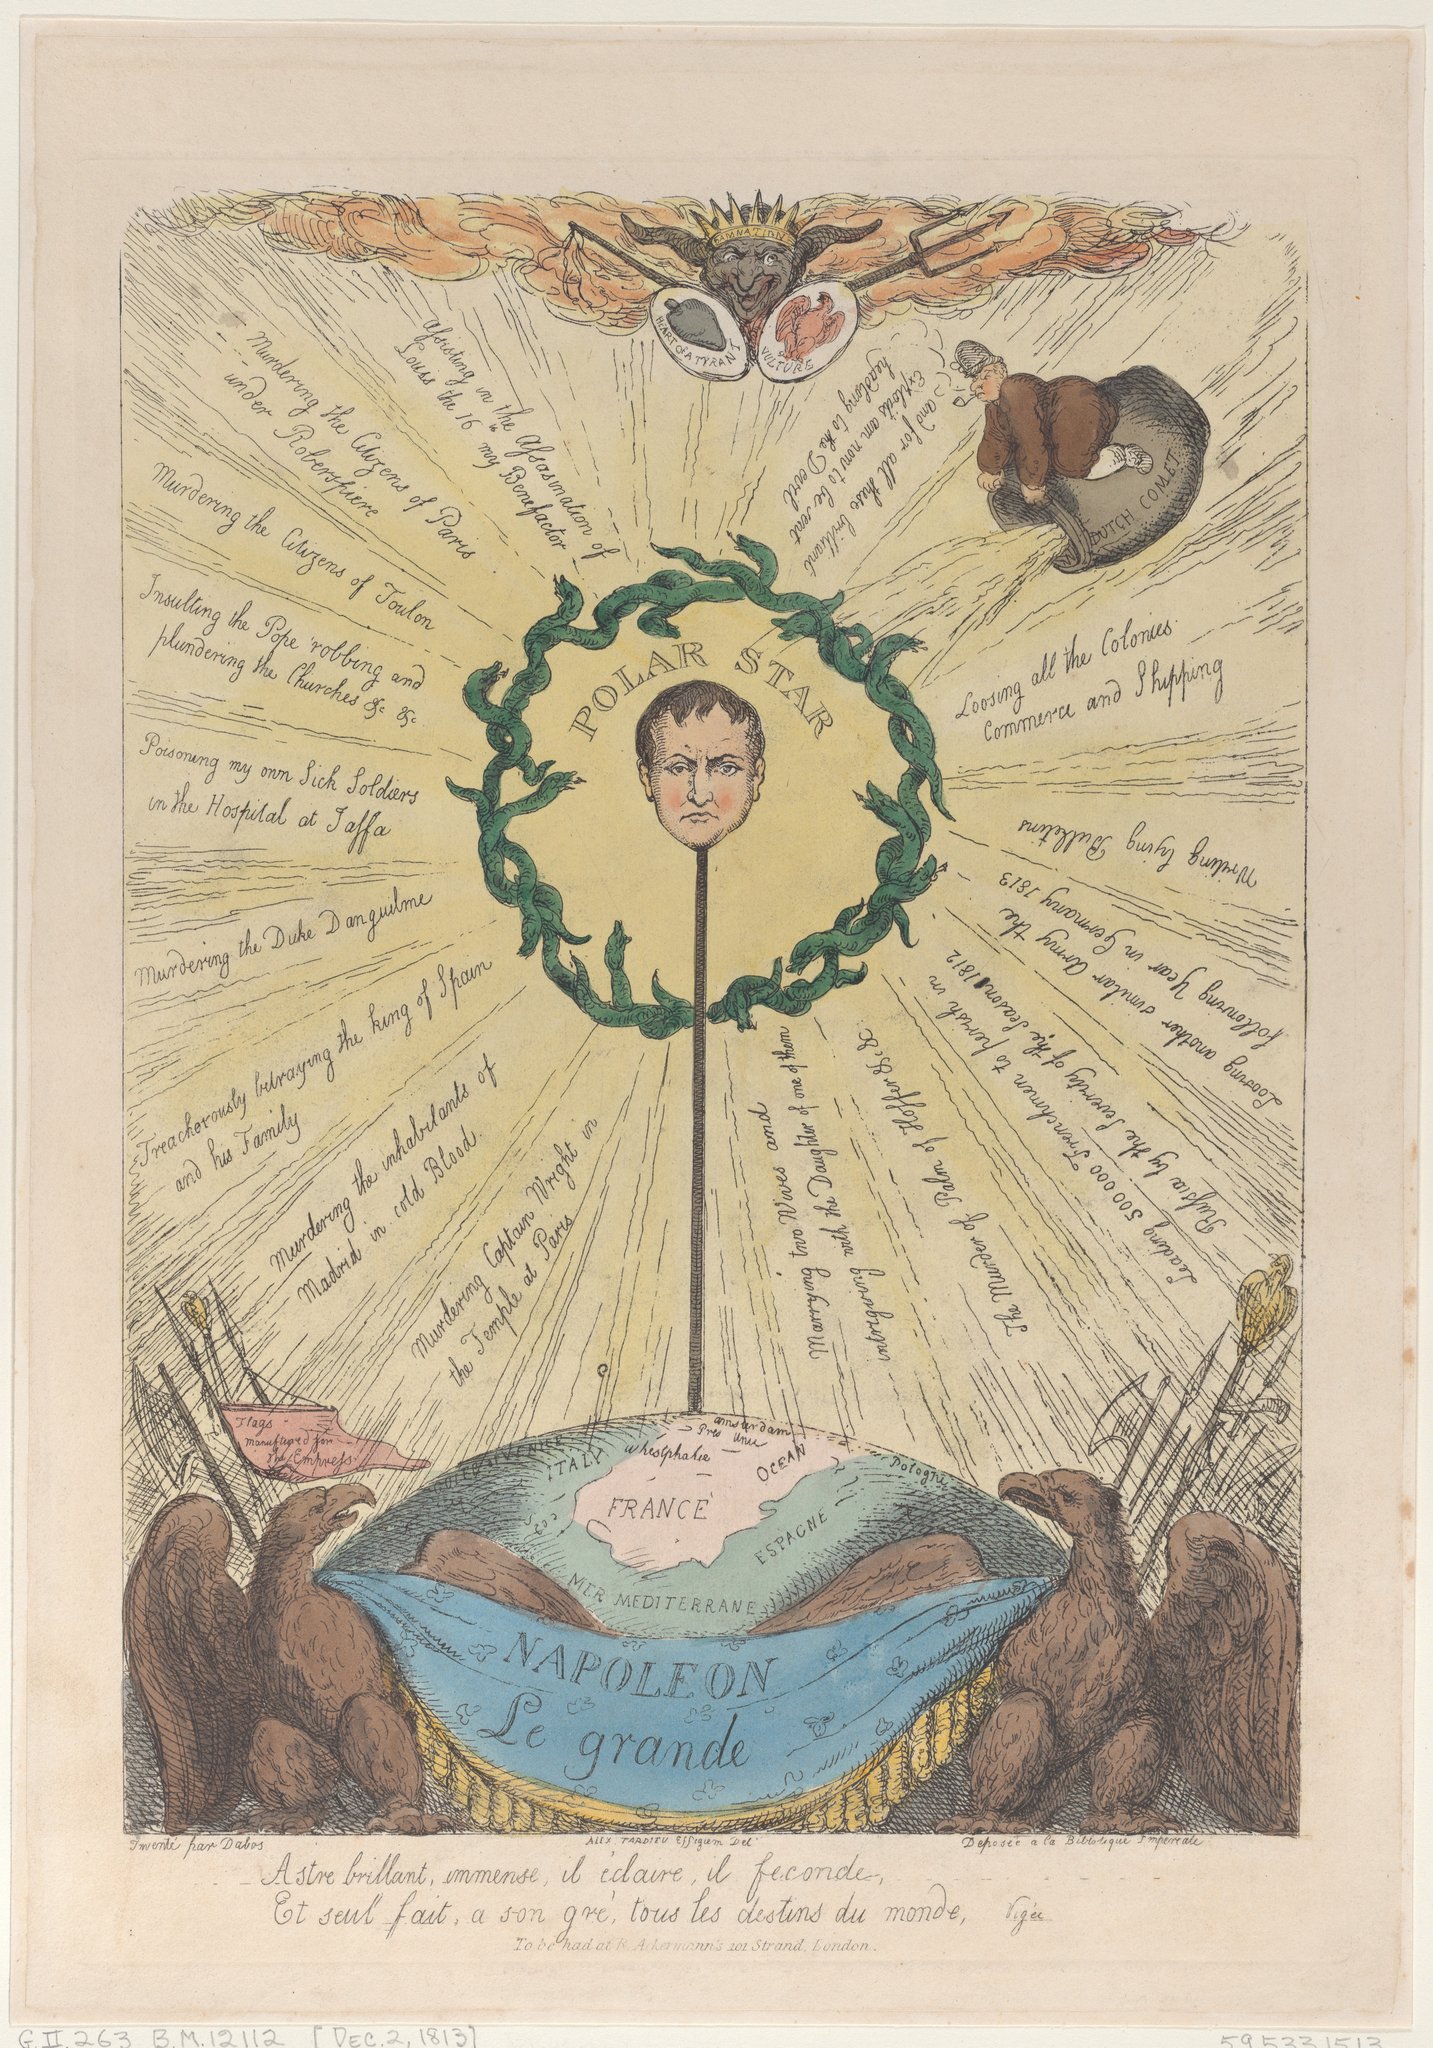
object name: print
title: Napleon Le Grande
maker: thomas rowlandson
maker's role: artist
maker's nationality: british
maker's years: 1757-1827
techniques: etching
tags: eagles,satire,napoleon i,allegory,politics